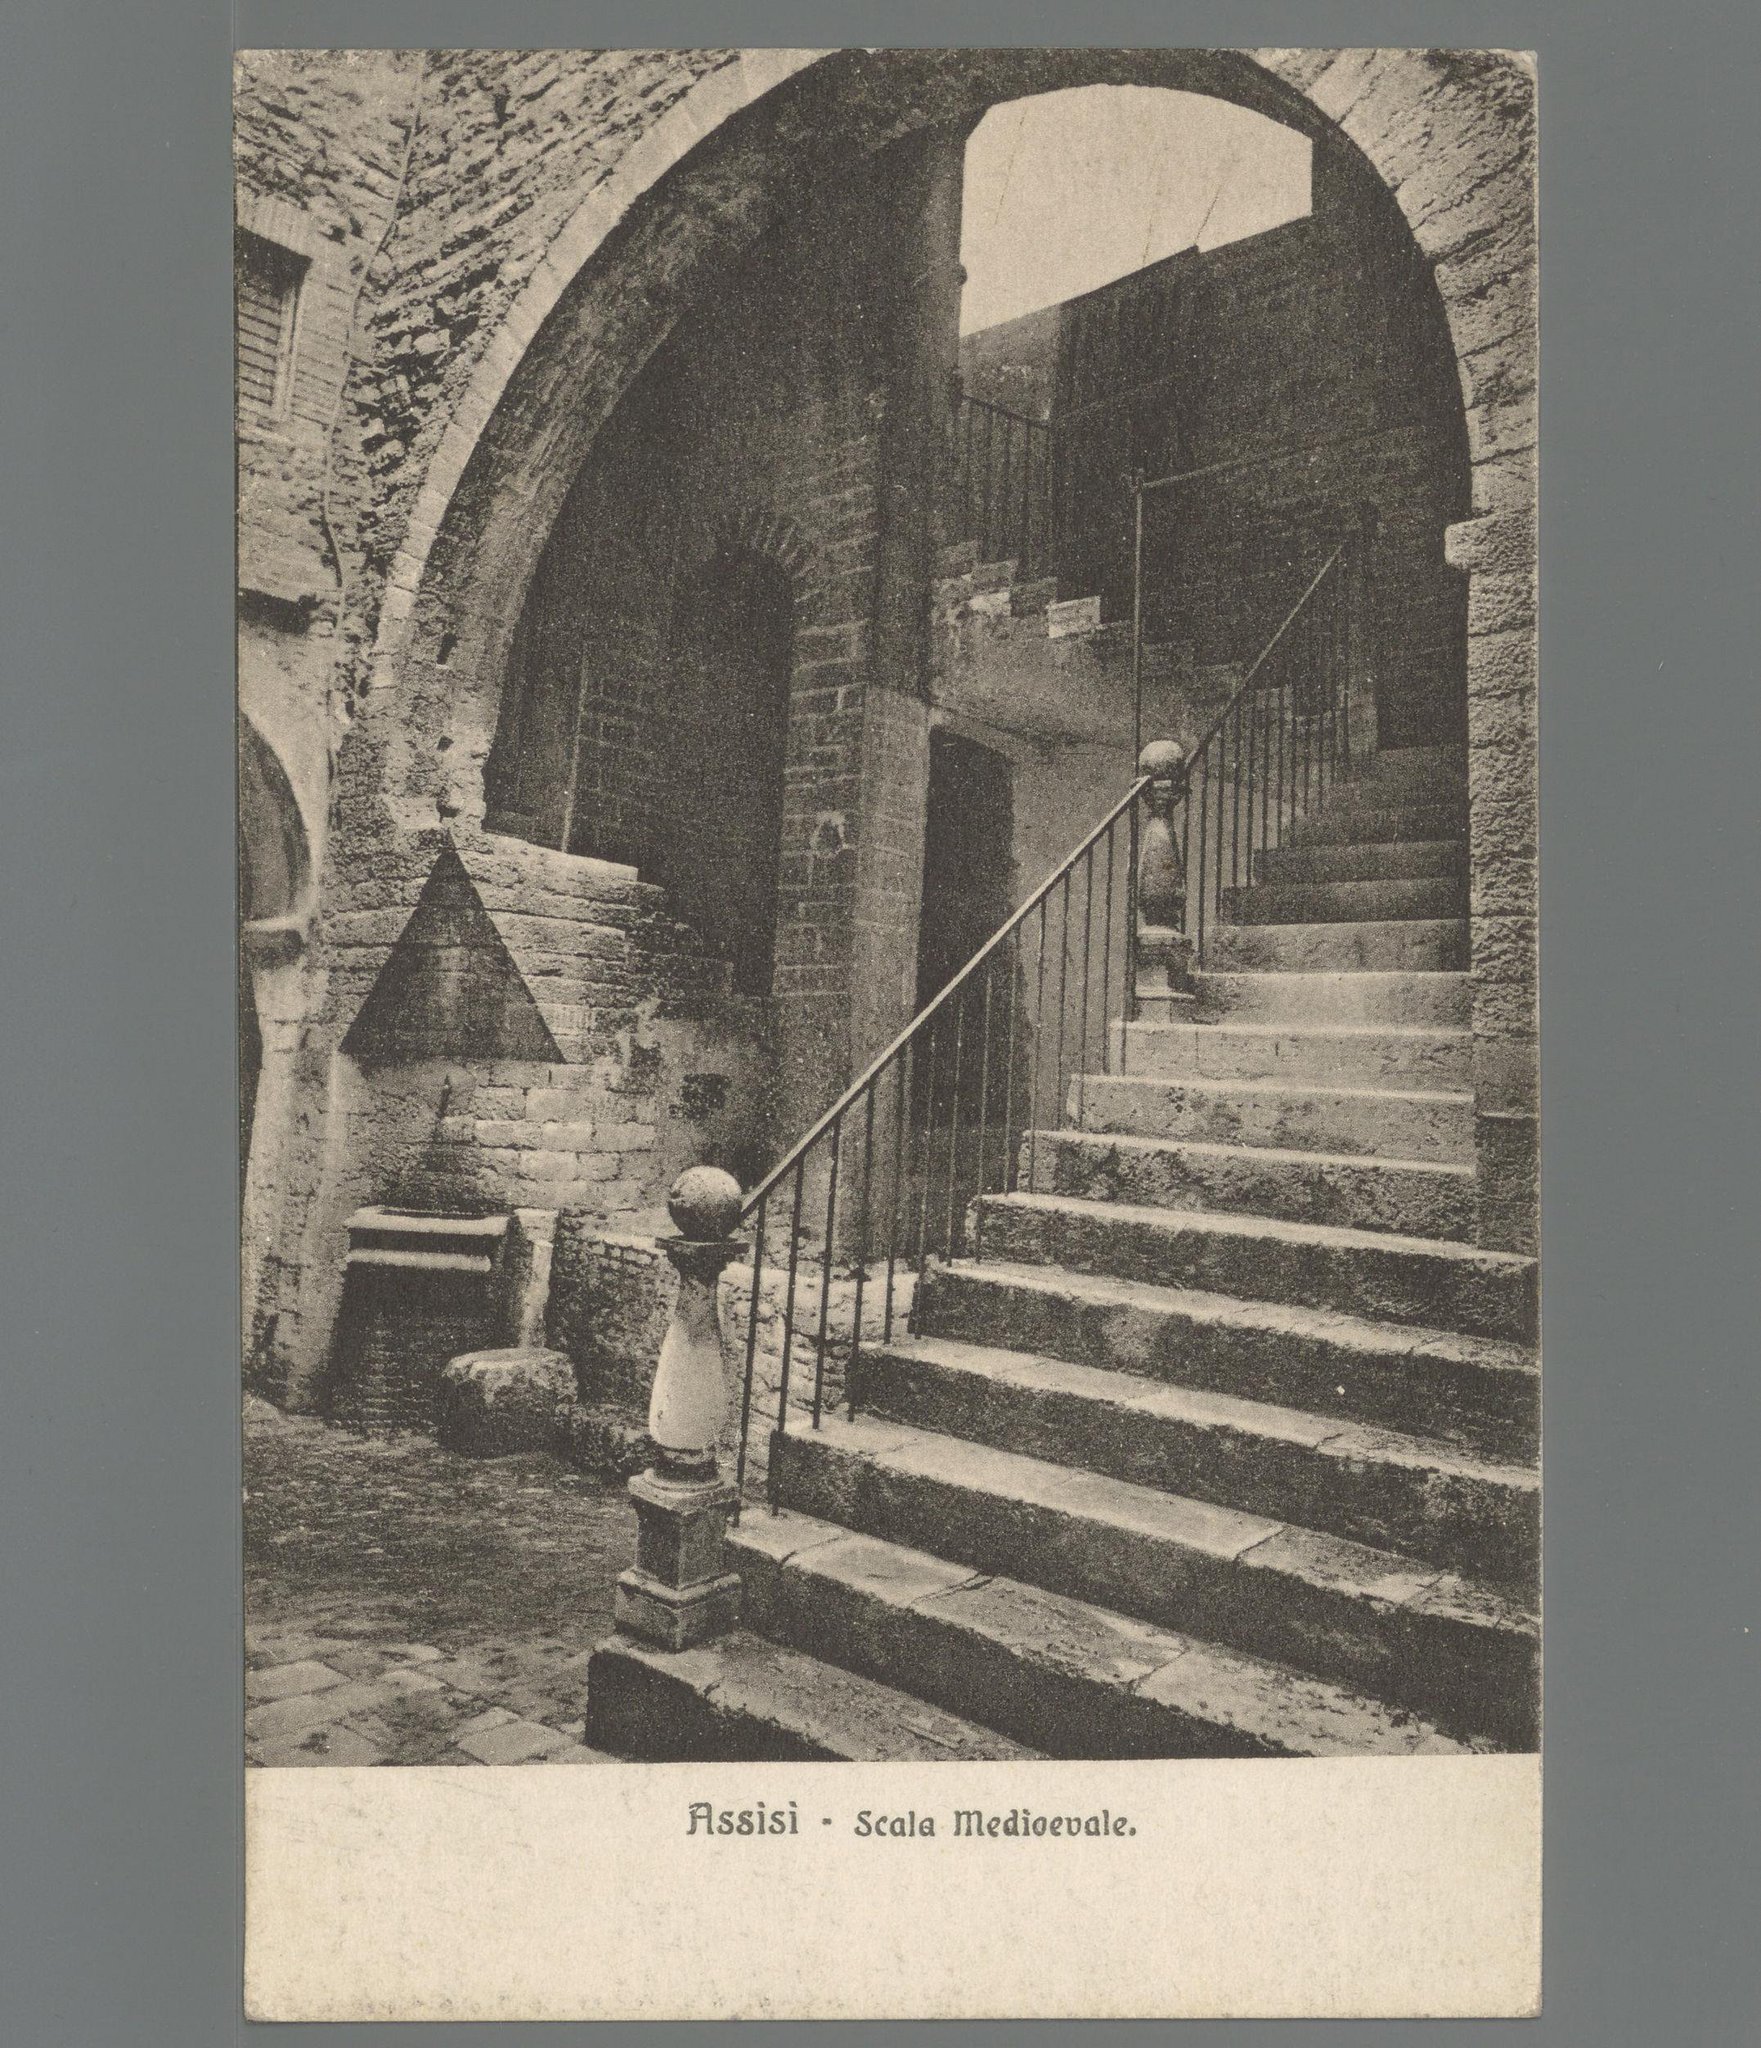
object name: ansichtkaart, prentbriefkaart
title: Assisi. Scala Medioevale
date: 1906-1923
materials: cardboard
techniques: photograph, writing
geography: assisi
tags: staircase, courtyard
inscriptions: postage stamp